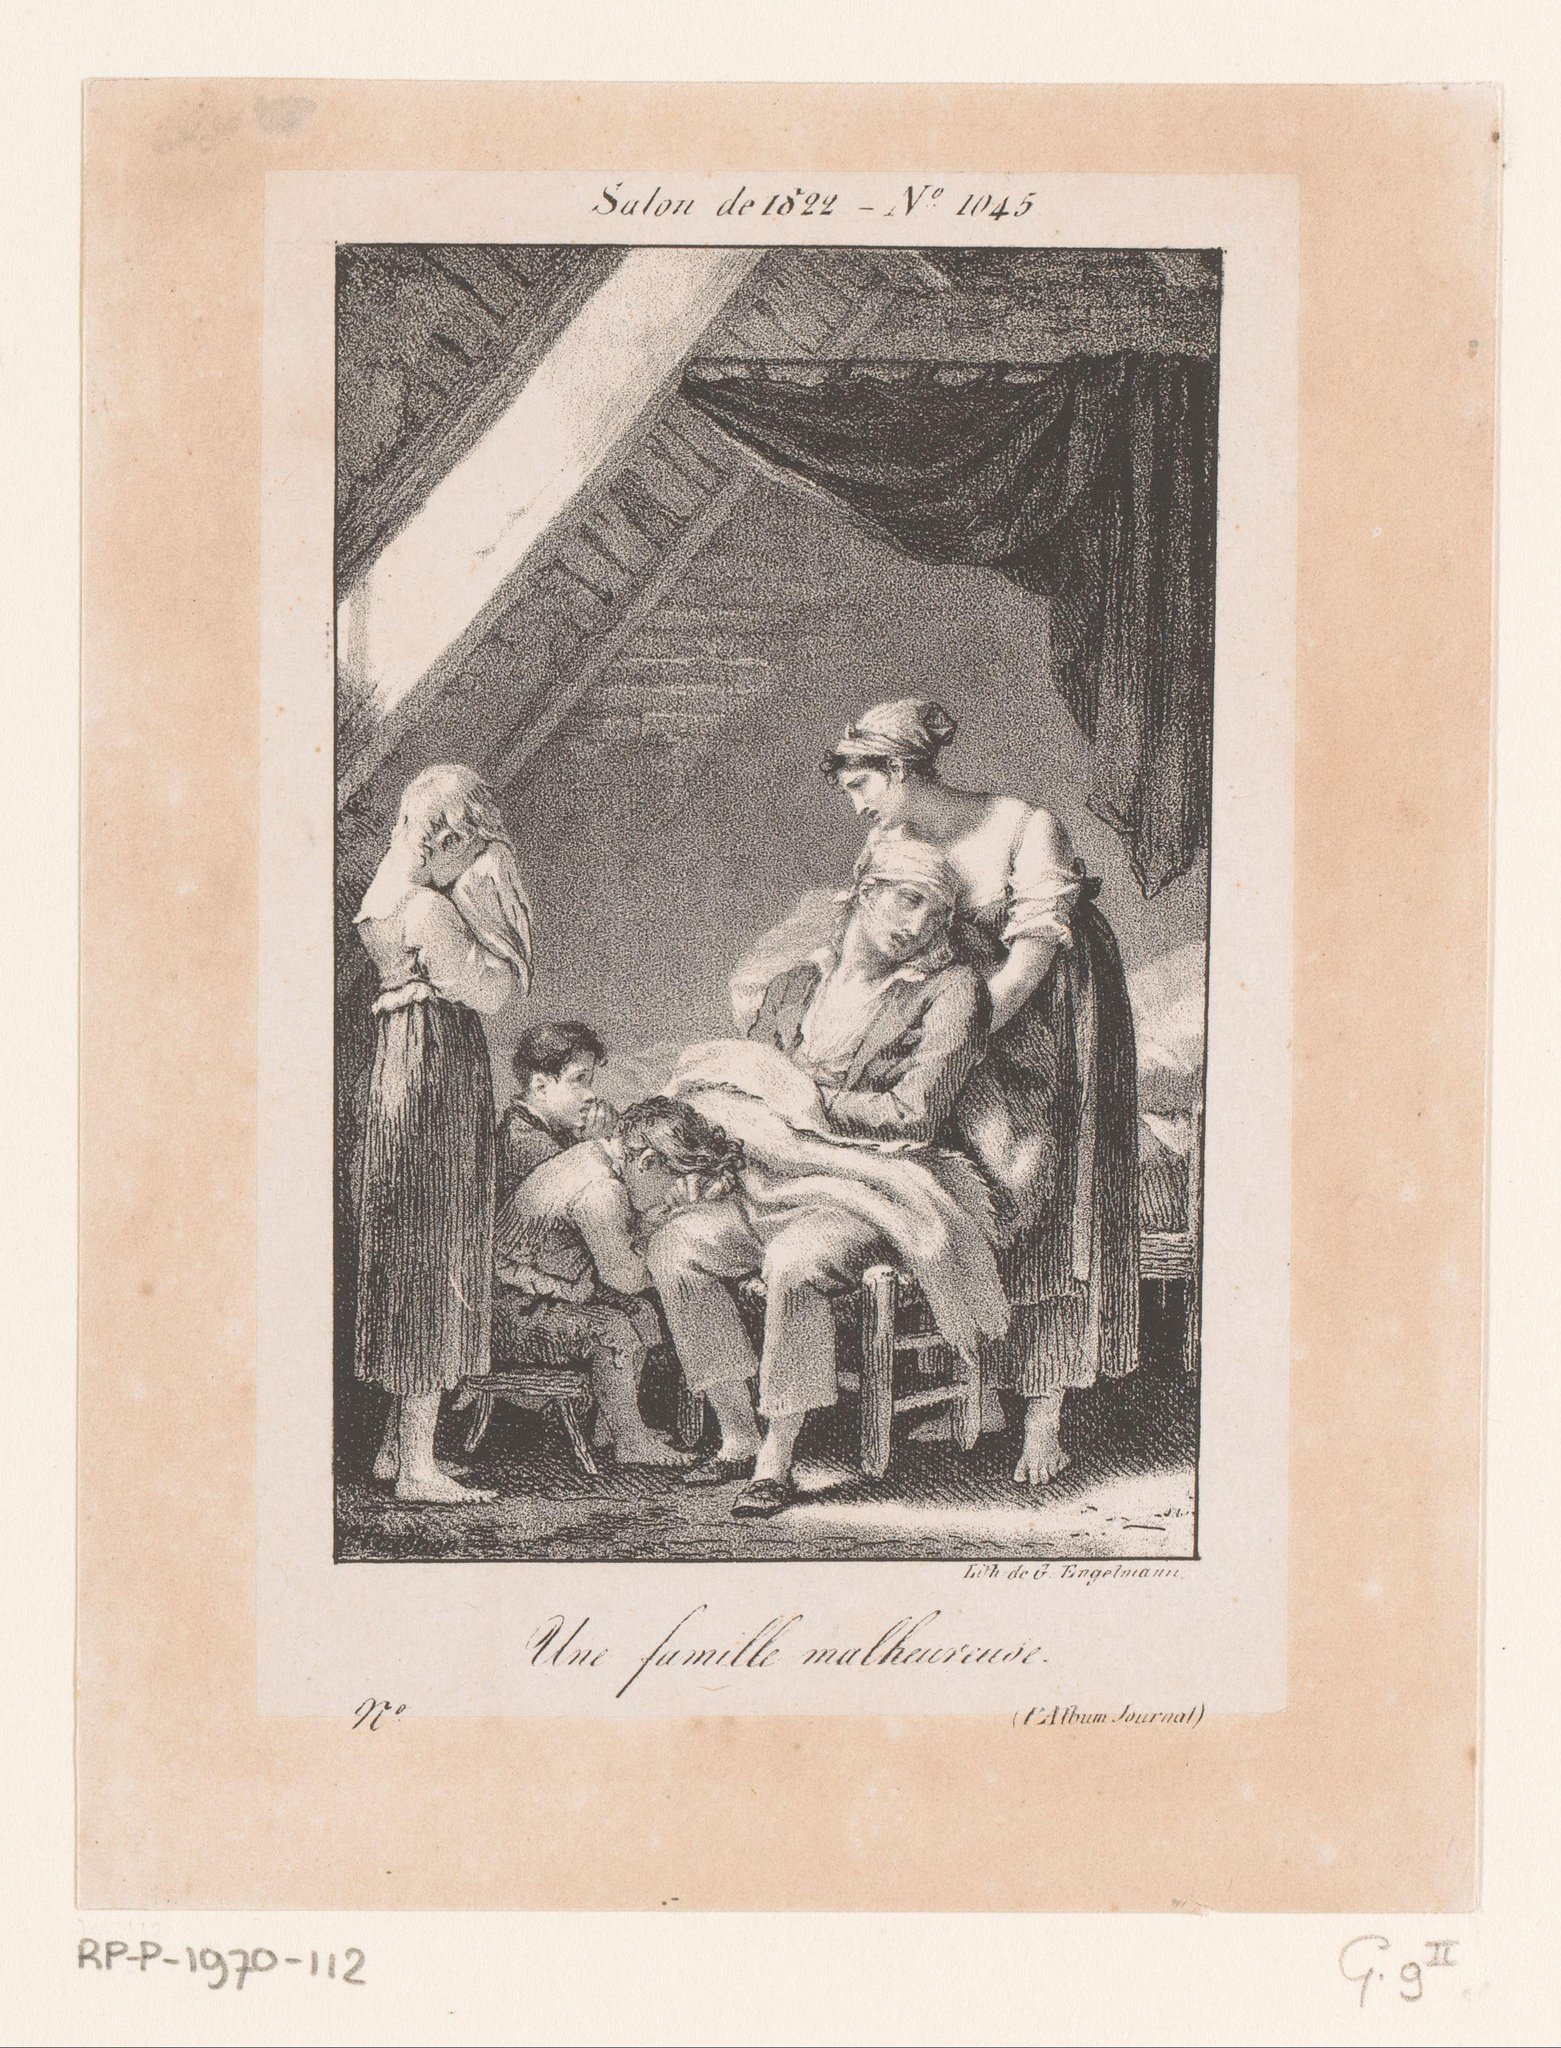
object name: print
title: Vrouw en kinderen treurend rond zieke man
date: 1822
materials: paper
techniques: lithograph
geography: paris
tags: family, relationship, descent, patient, sick person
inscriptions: collector's mark: Lugt 2760, collector's mark: Lugt 2228